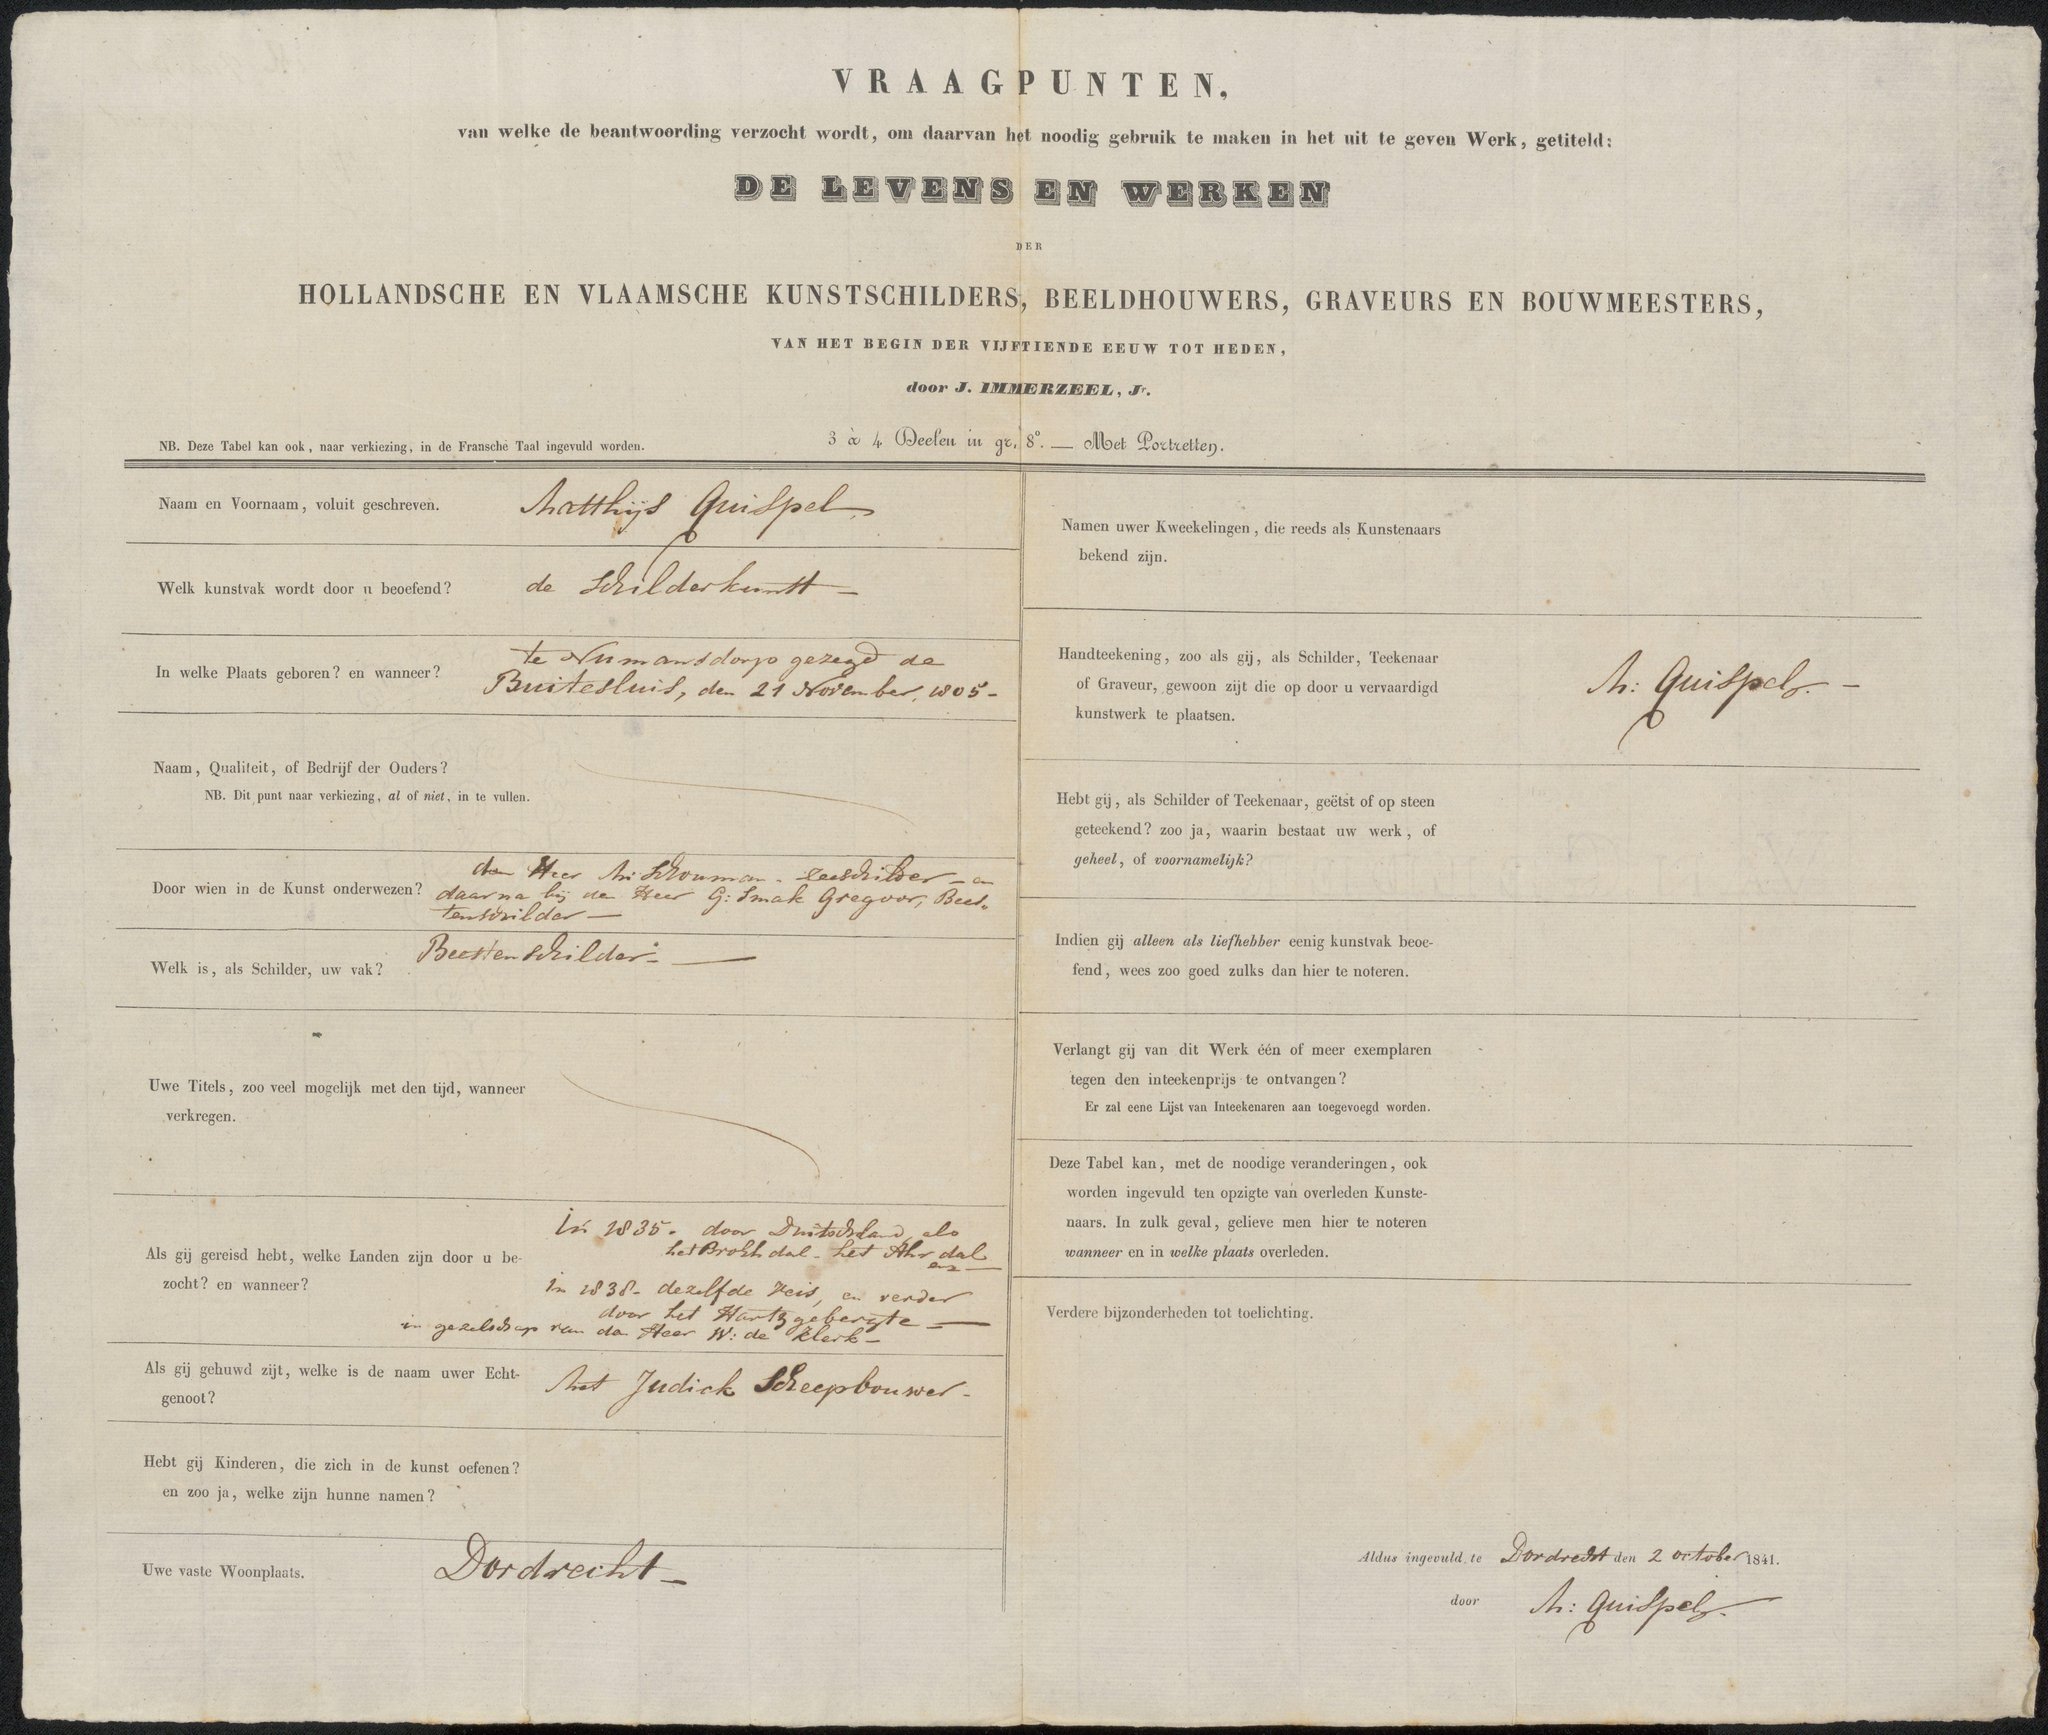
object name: questionnaire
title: Enquêteformulier ingevuld door Matthijs Quispel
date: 1841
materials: ink, paper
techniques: pen, printing, writing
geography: dordrecht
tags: dordrecht, painter, draughtsman, matthijs quispel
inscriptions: inscription: ‘Vraagpunten,/ van welke de beantwoording verzocht wordt, om daarvan het noodig gebruik te maken in het uit te geven Werk, getiteld: De levens en werken/ der Hollandsche en Vlaamsche kunstschilders, beeldhouwers,/ graveurs en bouwmeesters, van het begin der vijftiende eeuw tot heden/ door J. Immerzeel, Jr.’, watermark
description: Opgenomen in: Immerzeel, J. Jr., De levens en werken der Hollandsche en Vlaamsche kunstschilders, beeldhouwers, graveurs en bouwmeesters, van het begin der vijftiende eeuw tot heden, Amsterdam: J.C. van Kesteren, 1842-1843.